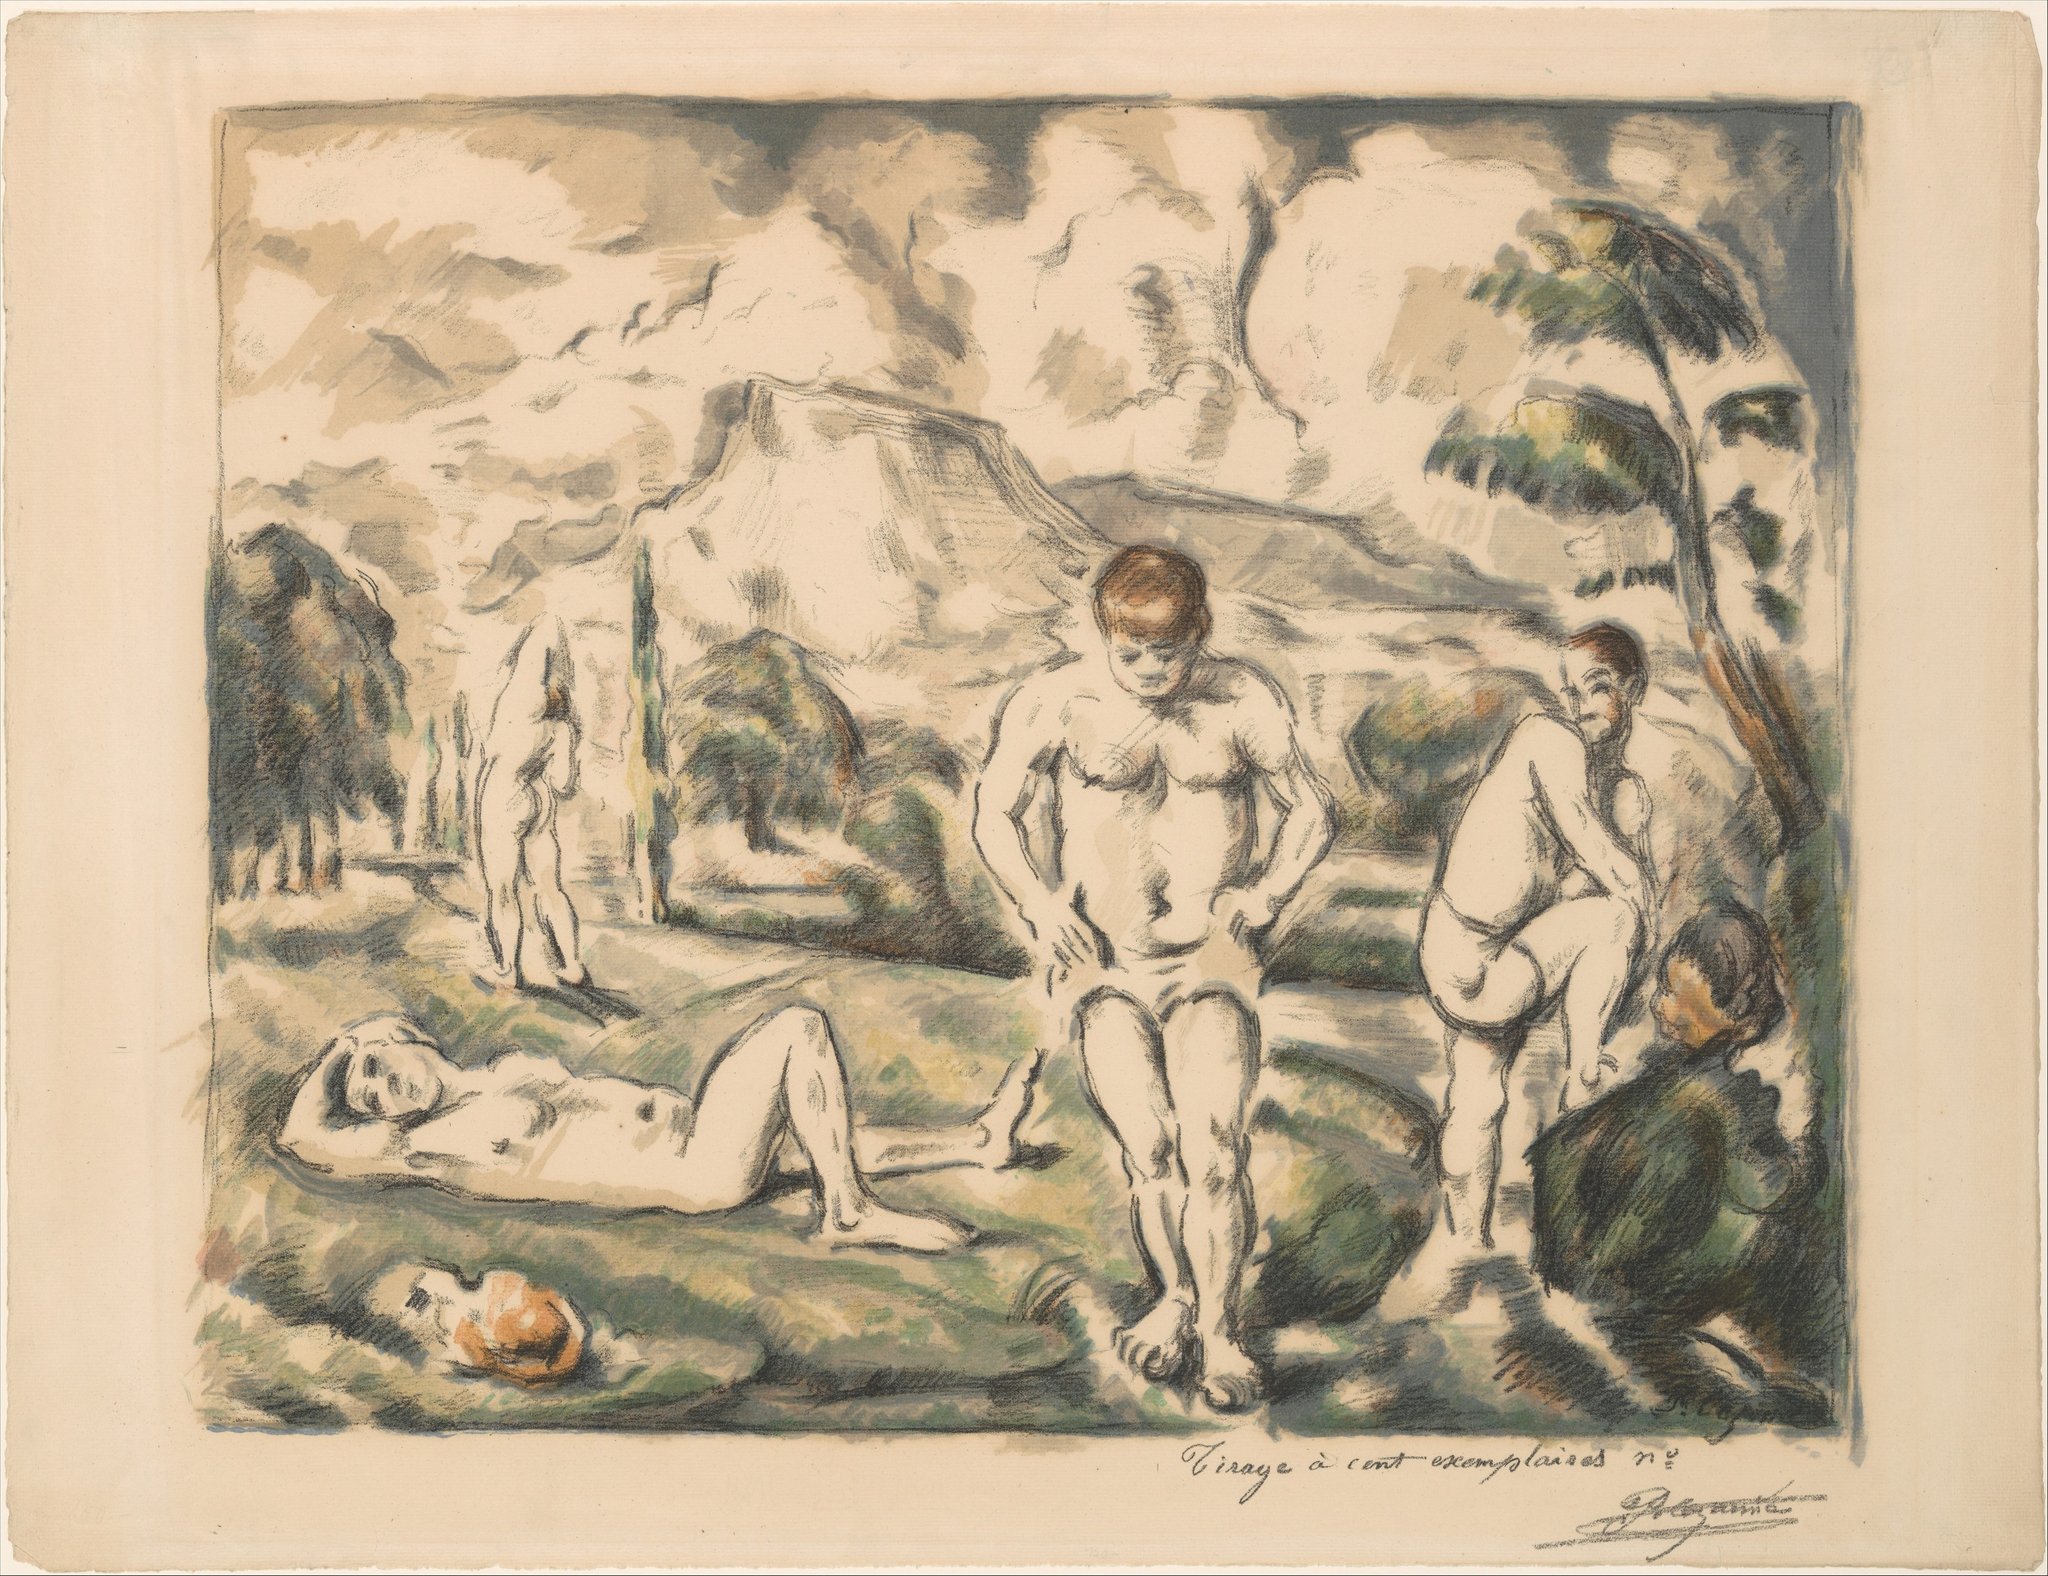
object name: print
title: The Large Bathers (Les Baigneurs)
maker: paul cézanne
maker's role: artist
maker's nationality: french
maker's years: 1839-1906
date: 1898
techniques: lithograph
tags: men,male nudes,landscapes,trees,bathing